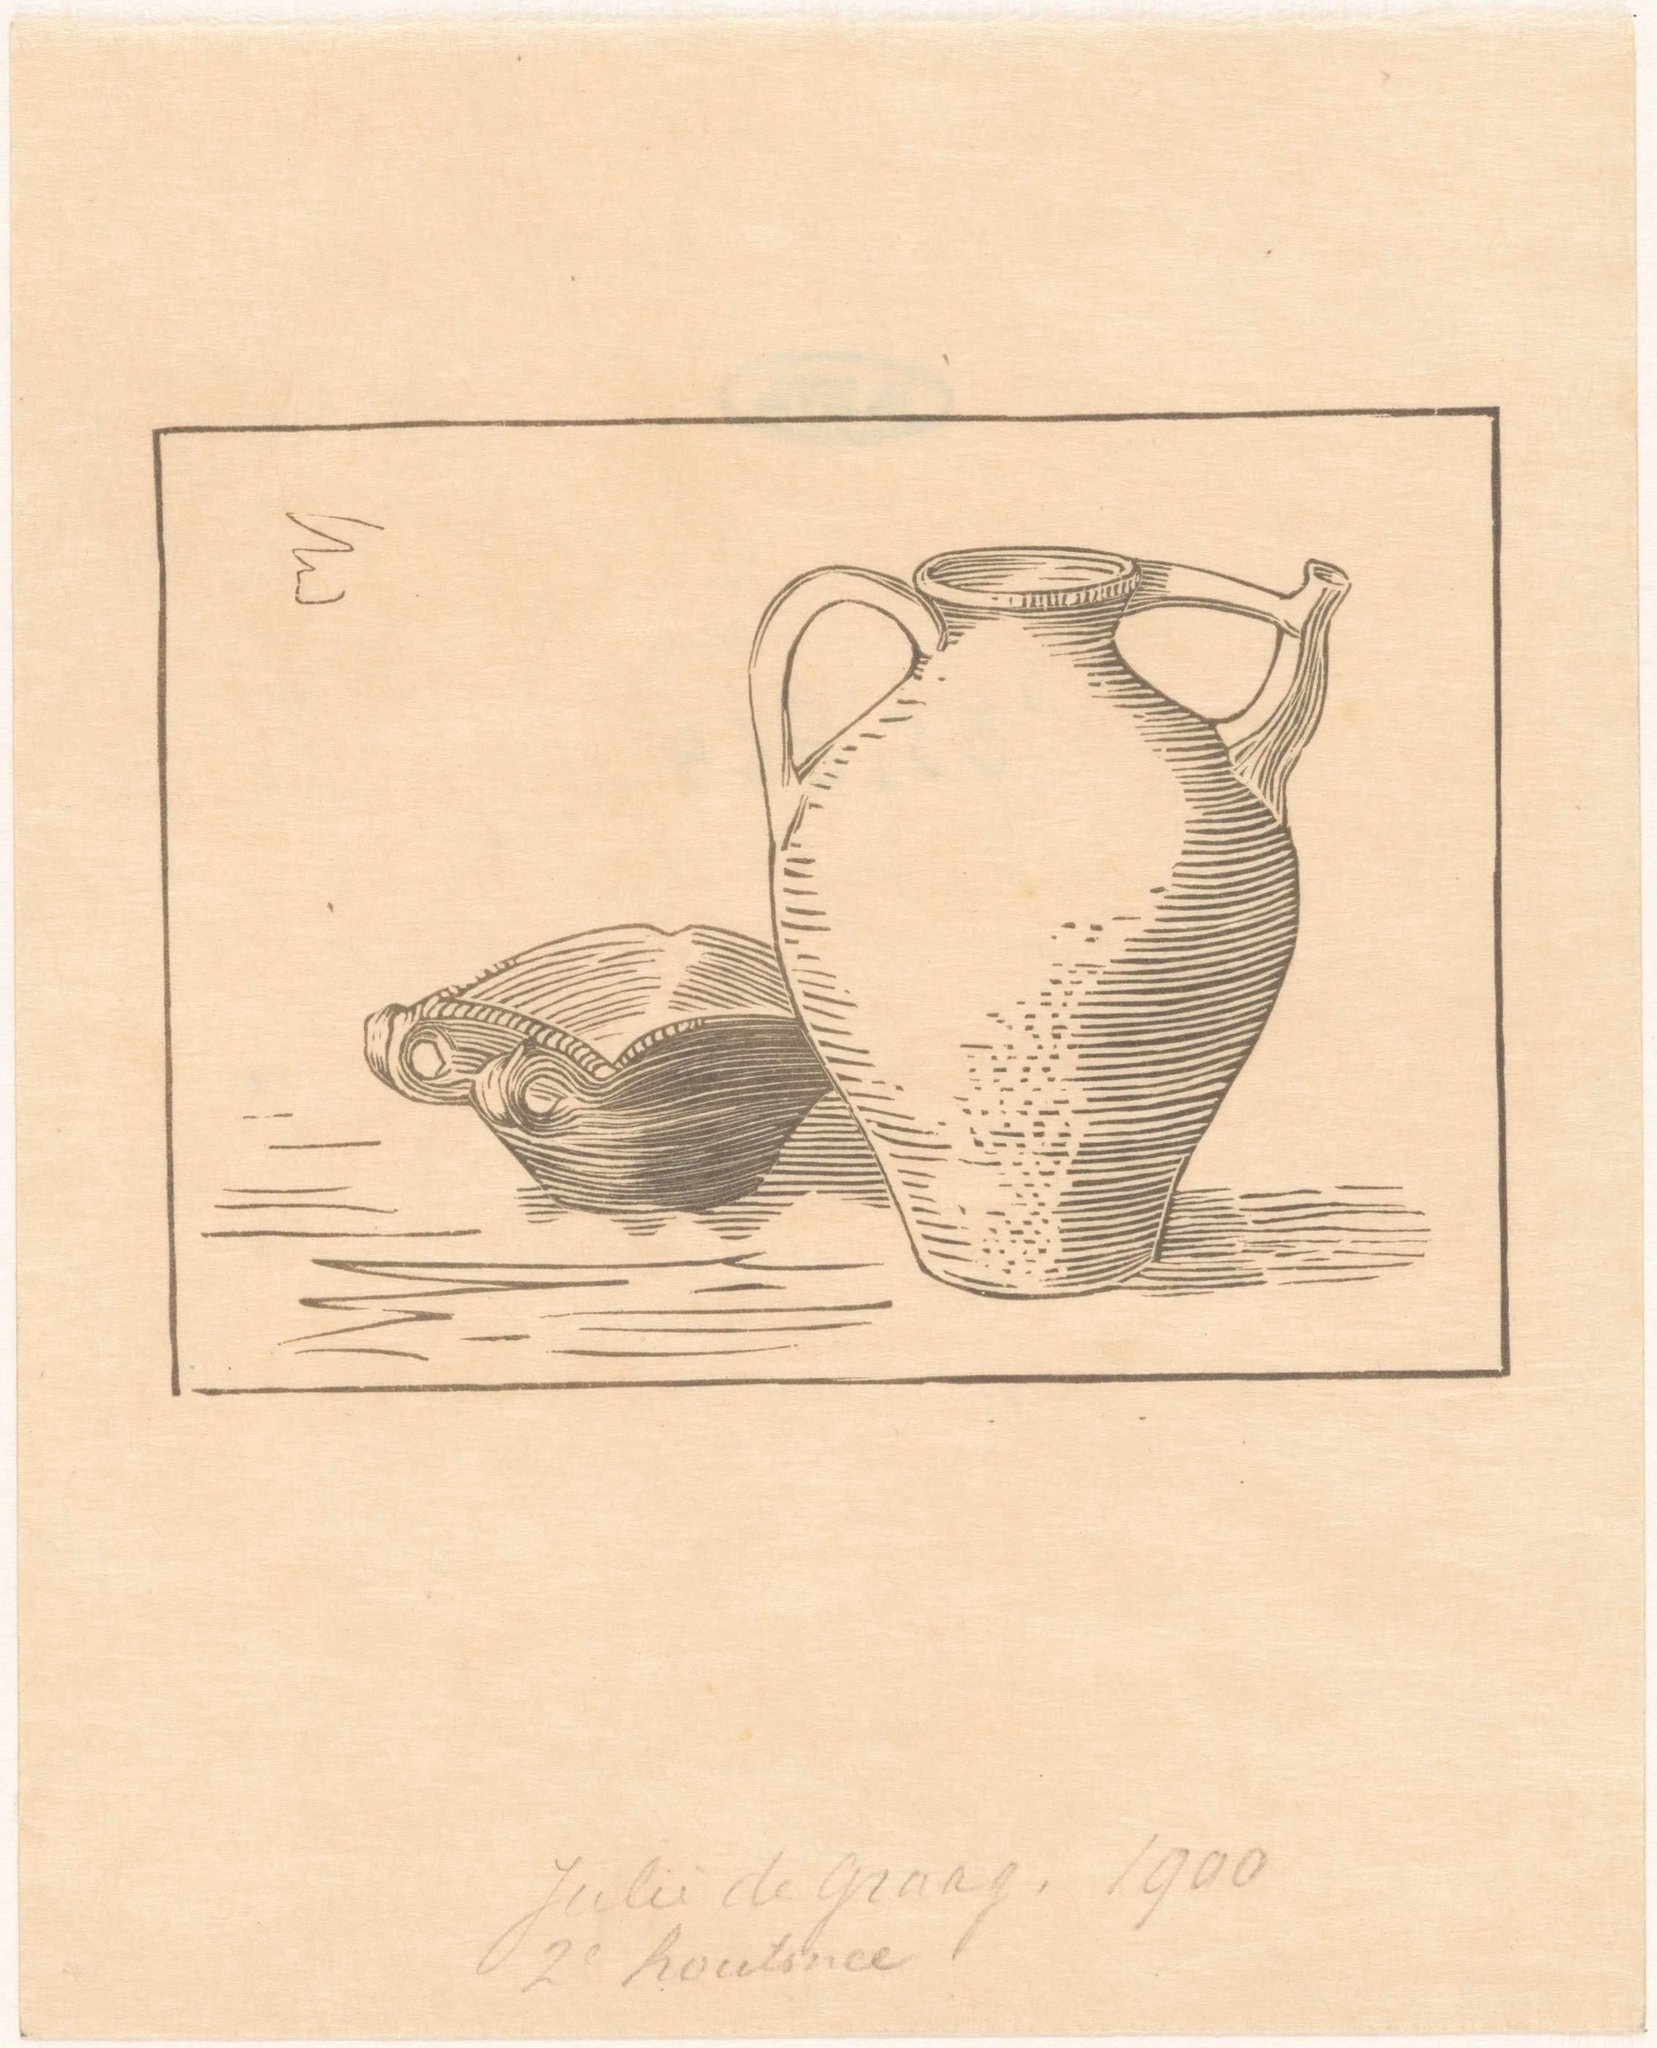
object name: print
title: Stilleven met kan en asbak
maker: julie de graag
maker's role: draughtsman, print maker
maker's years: 1877-1924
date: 1900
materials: paper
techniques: woodcut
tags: ashtray, container of ceramics: jar, jug, pot, vase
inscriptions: collector's mark: Lugt 2228, inscription: ‘2e houtsnee’